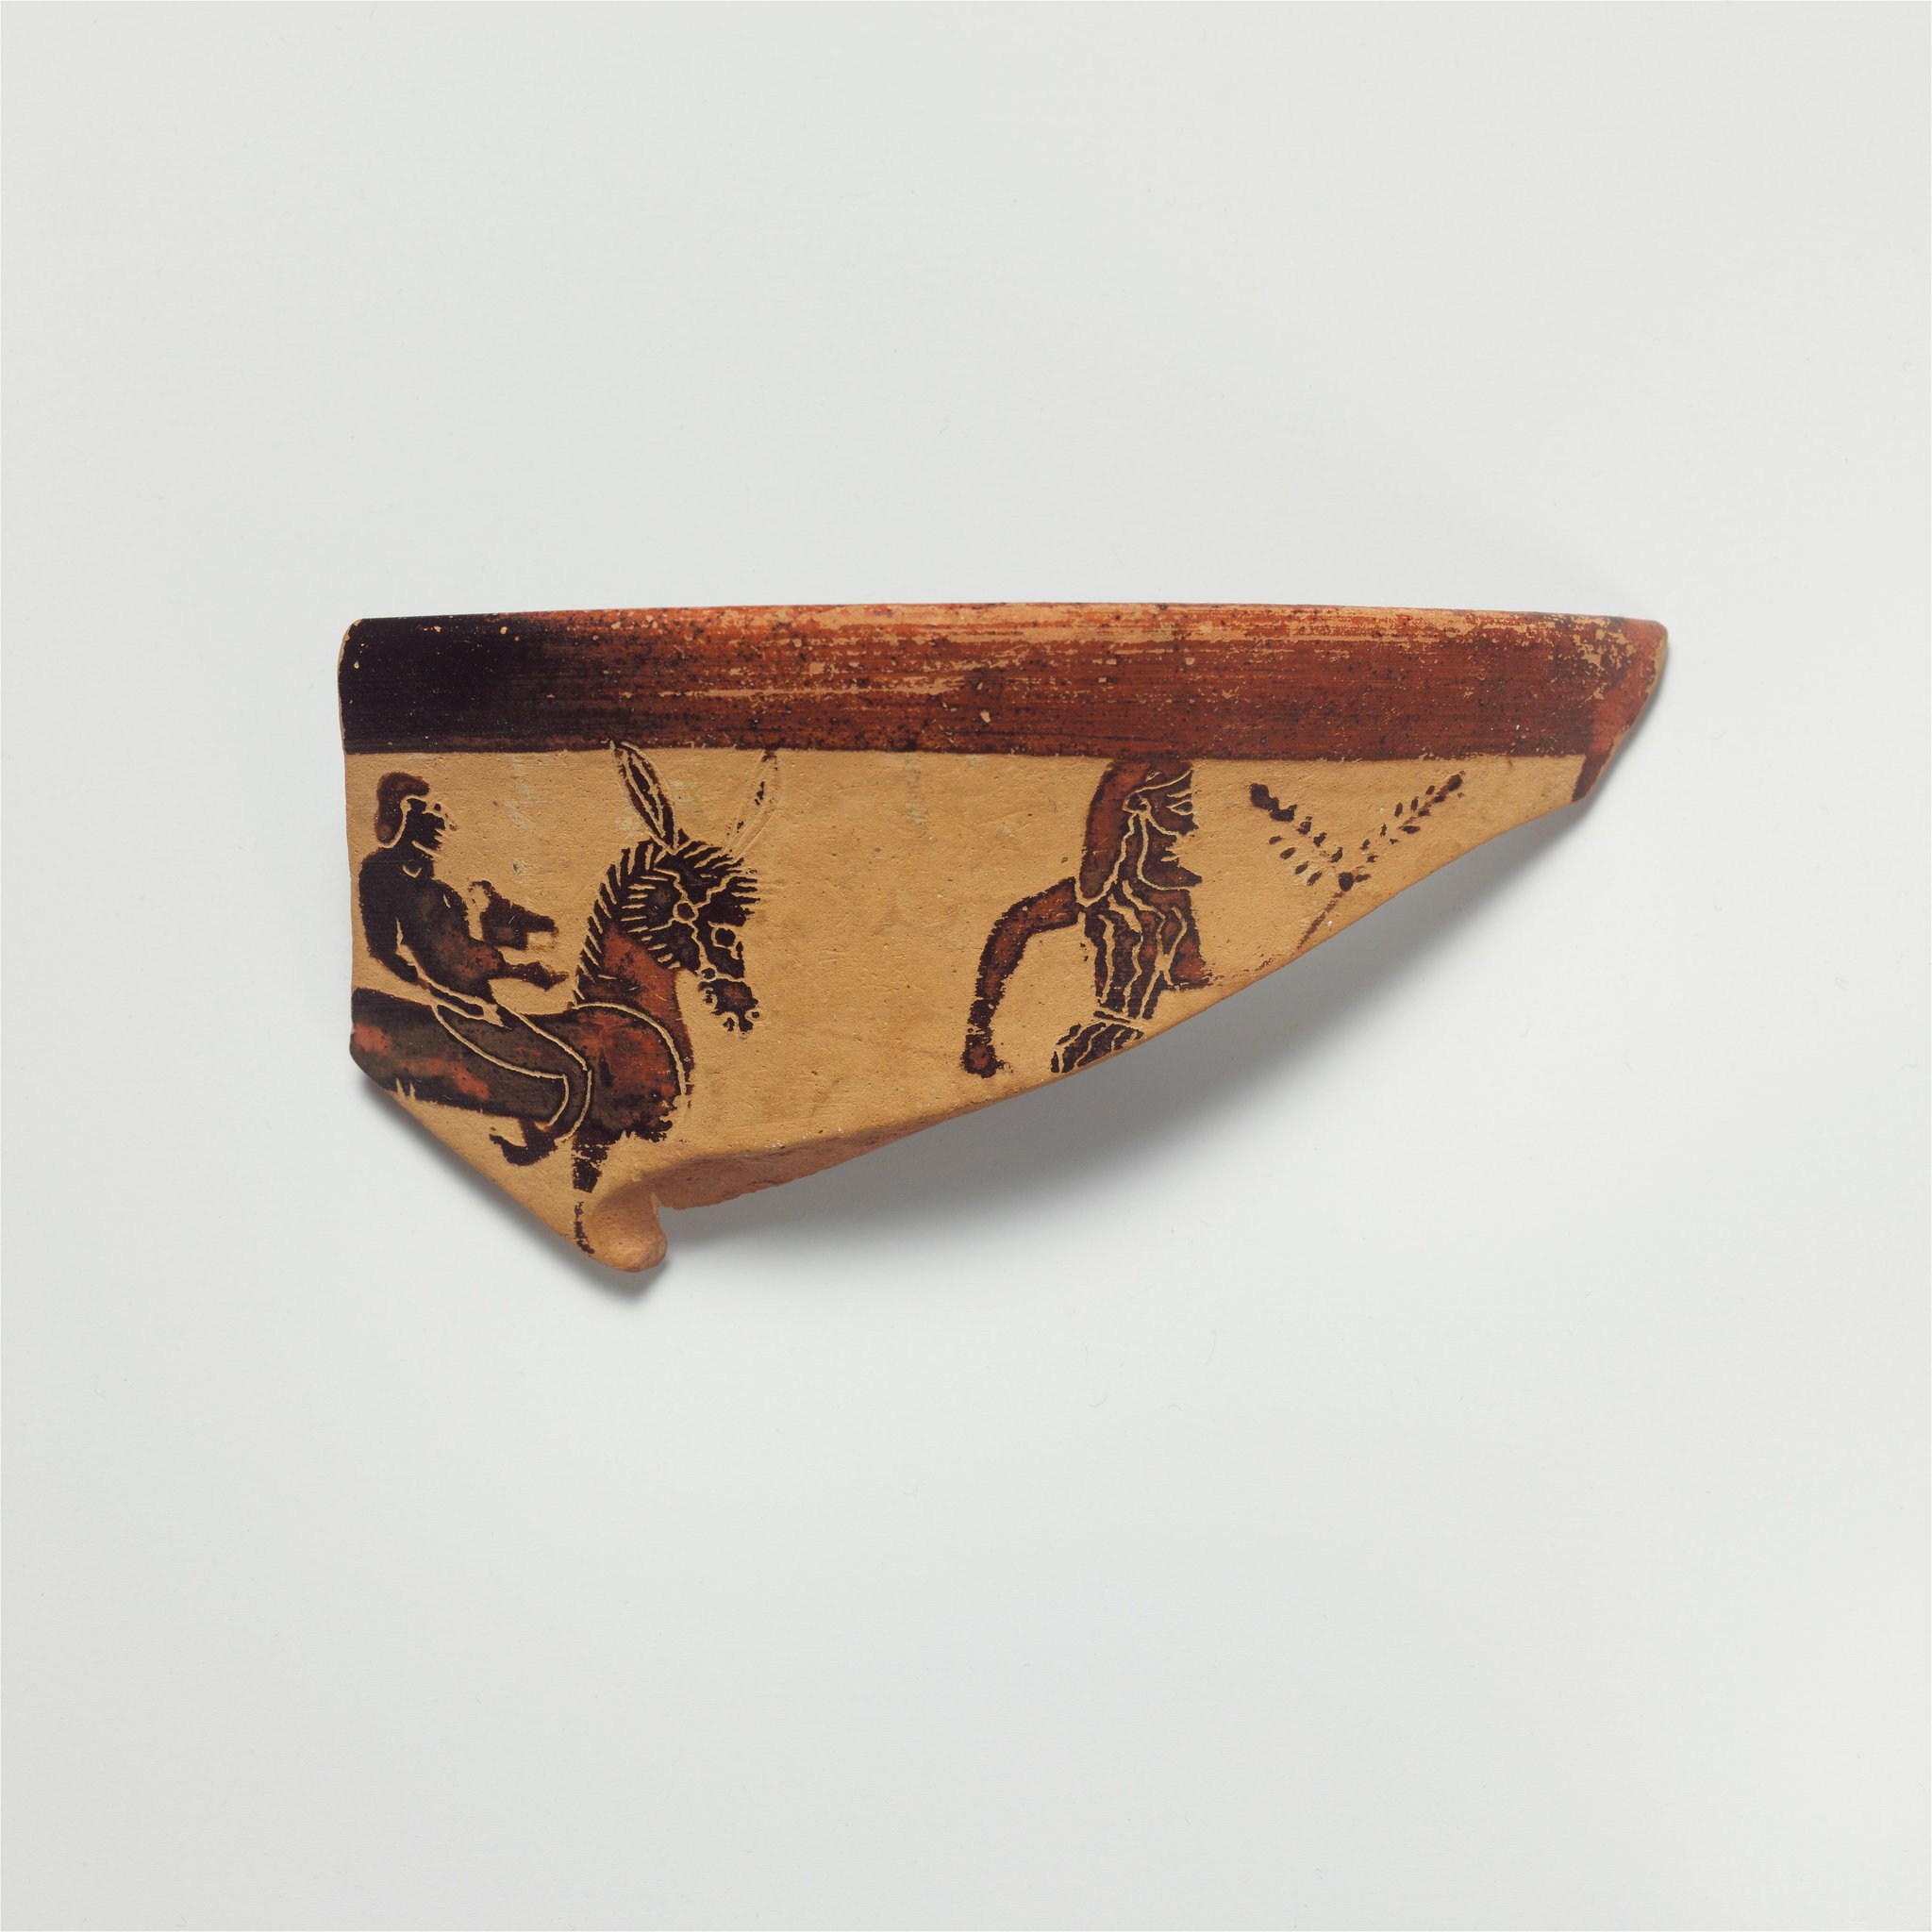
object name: kantharos fragment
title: Fragment of a terracotta kantharos (drinking cup with high handles)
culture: greek, boeotian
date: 500-468 BCE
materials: terracotta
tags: men,horses